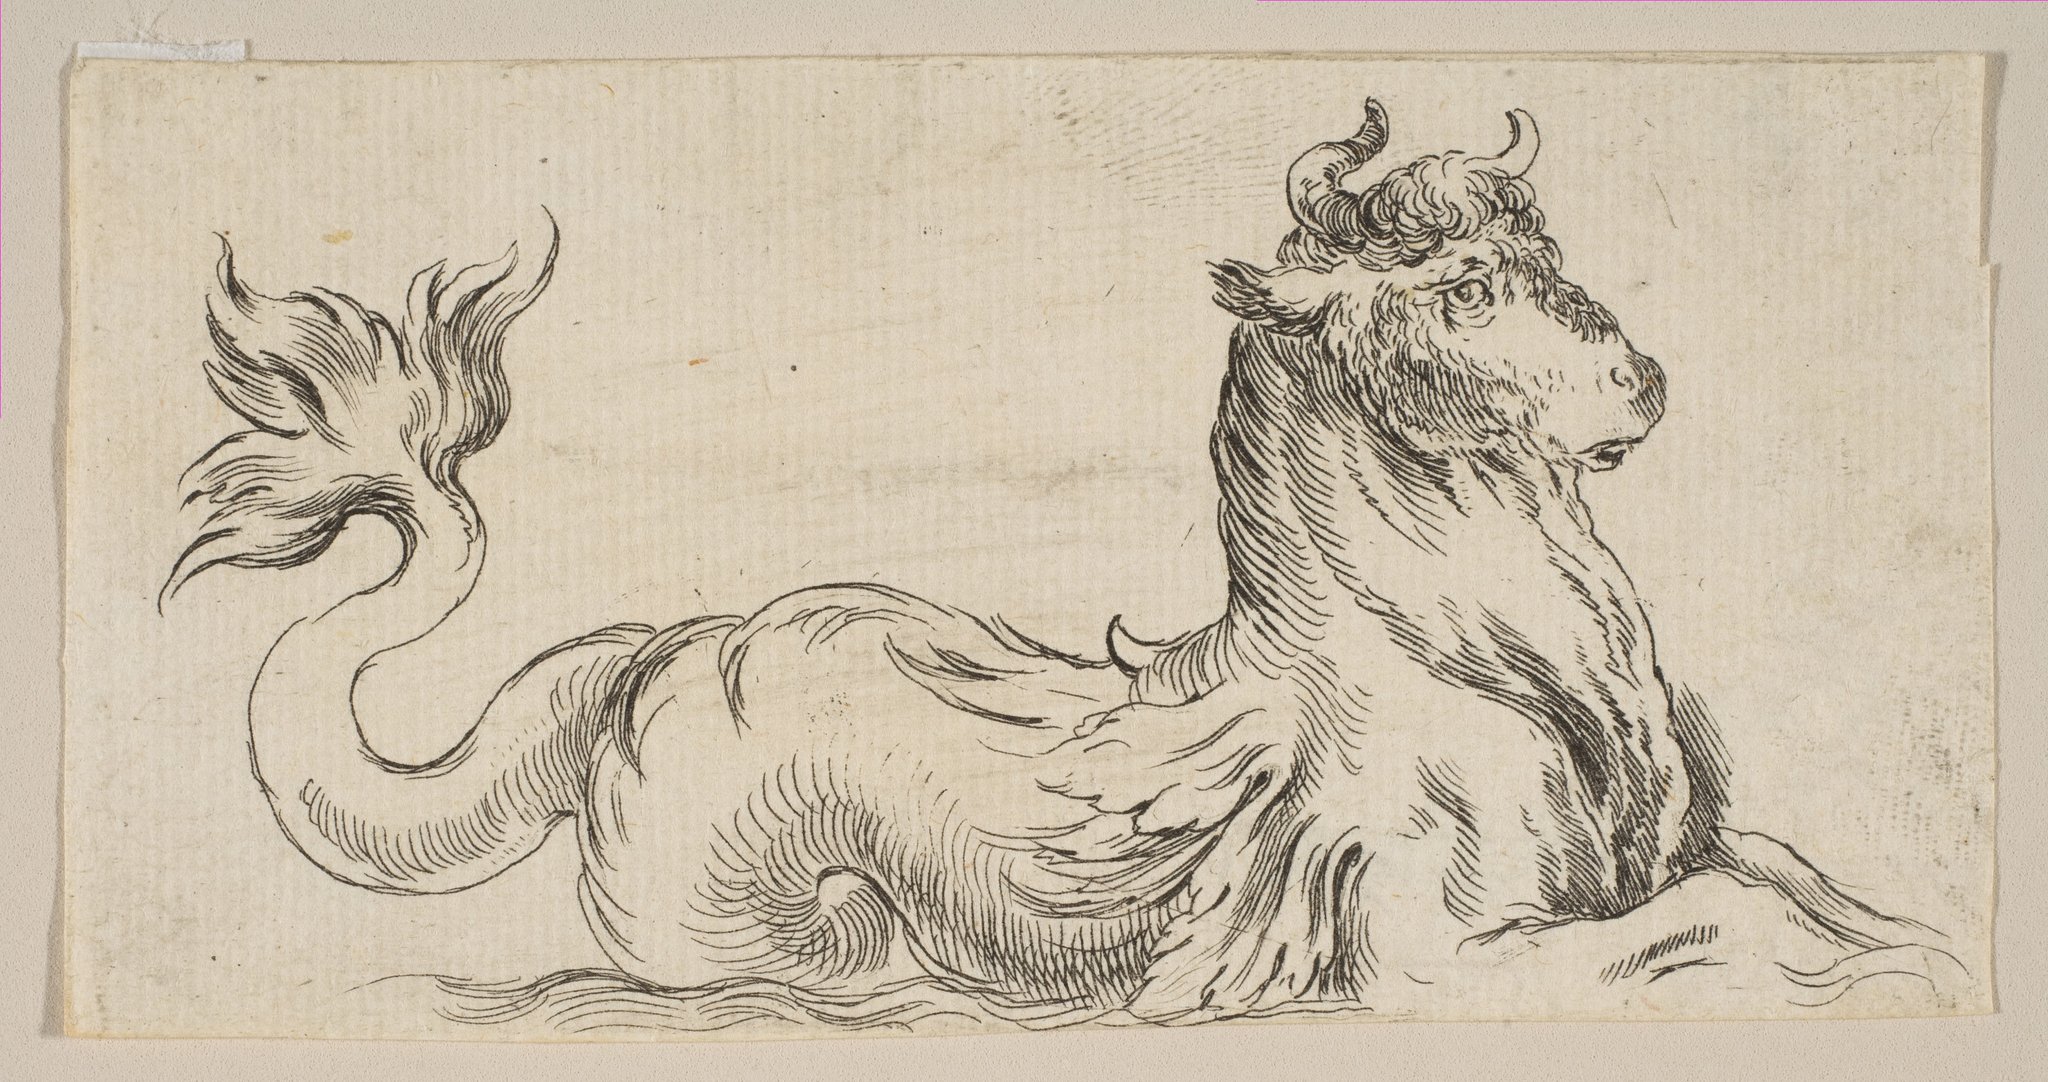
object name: print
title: Plate 9: Marine Bull, from "Various figures and doodles" (Diverses figures et griffonnemens)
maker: stefano della bella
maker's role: artist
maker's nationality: italian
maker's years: 1610-1664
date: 1646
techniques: etching